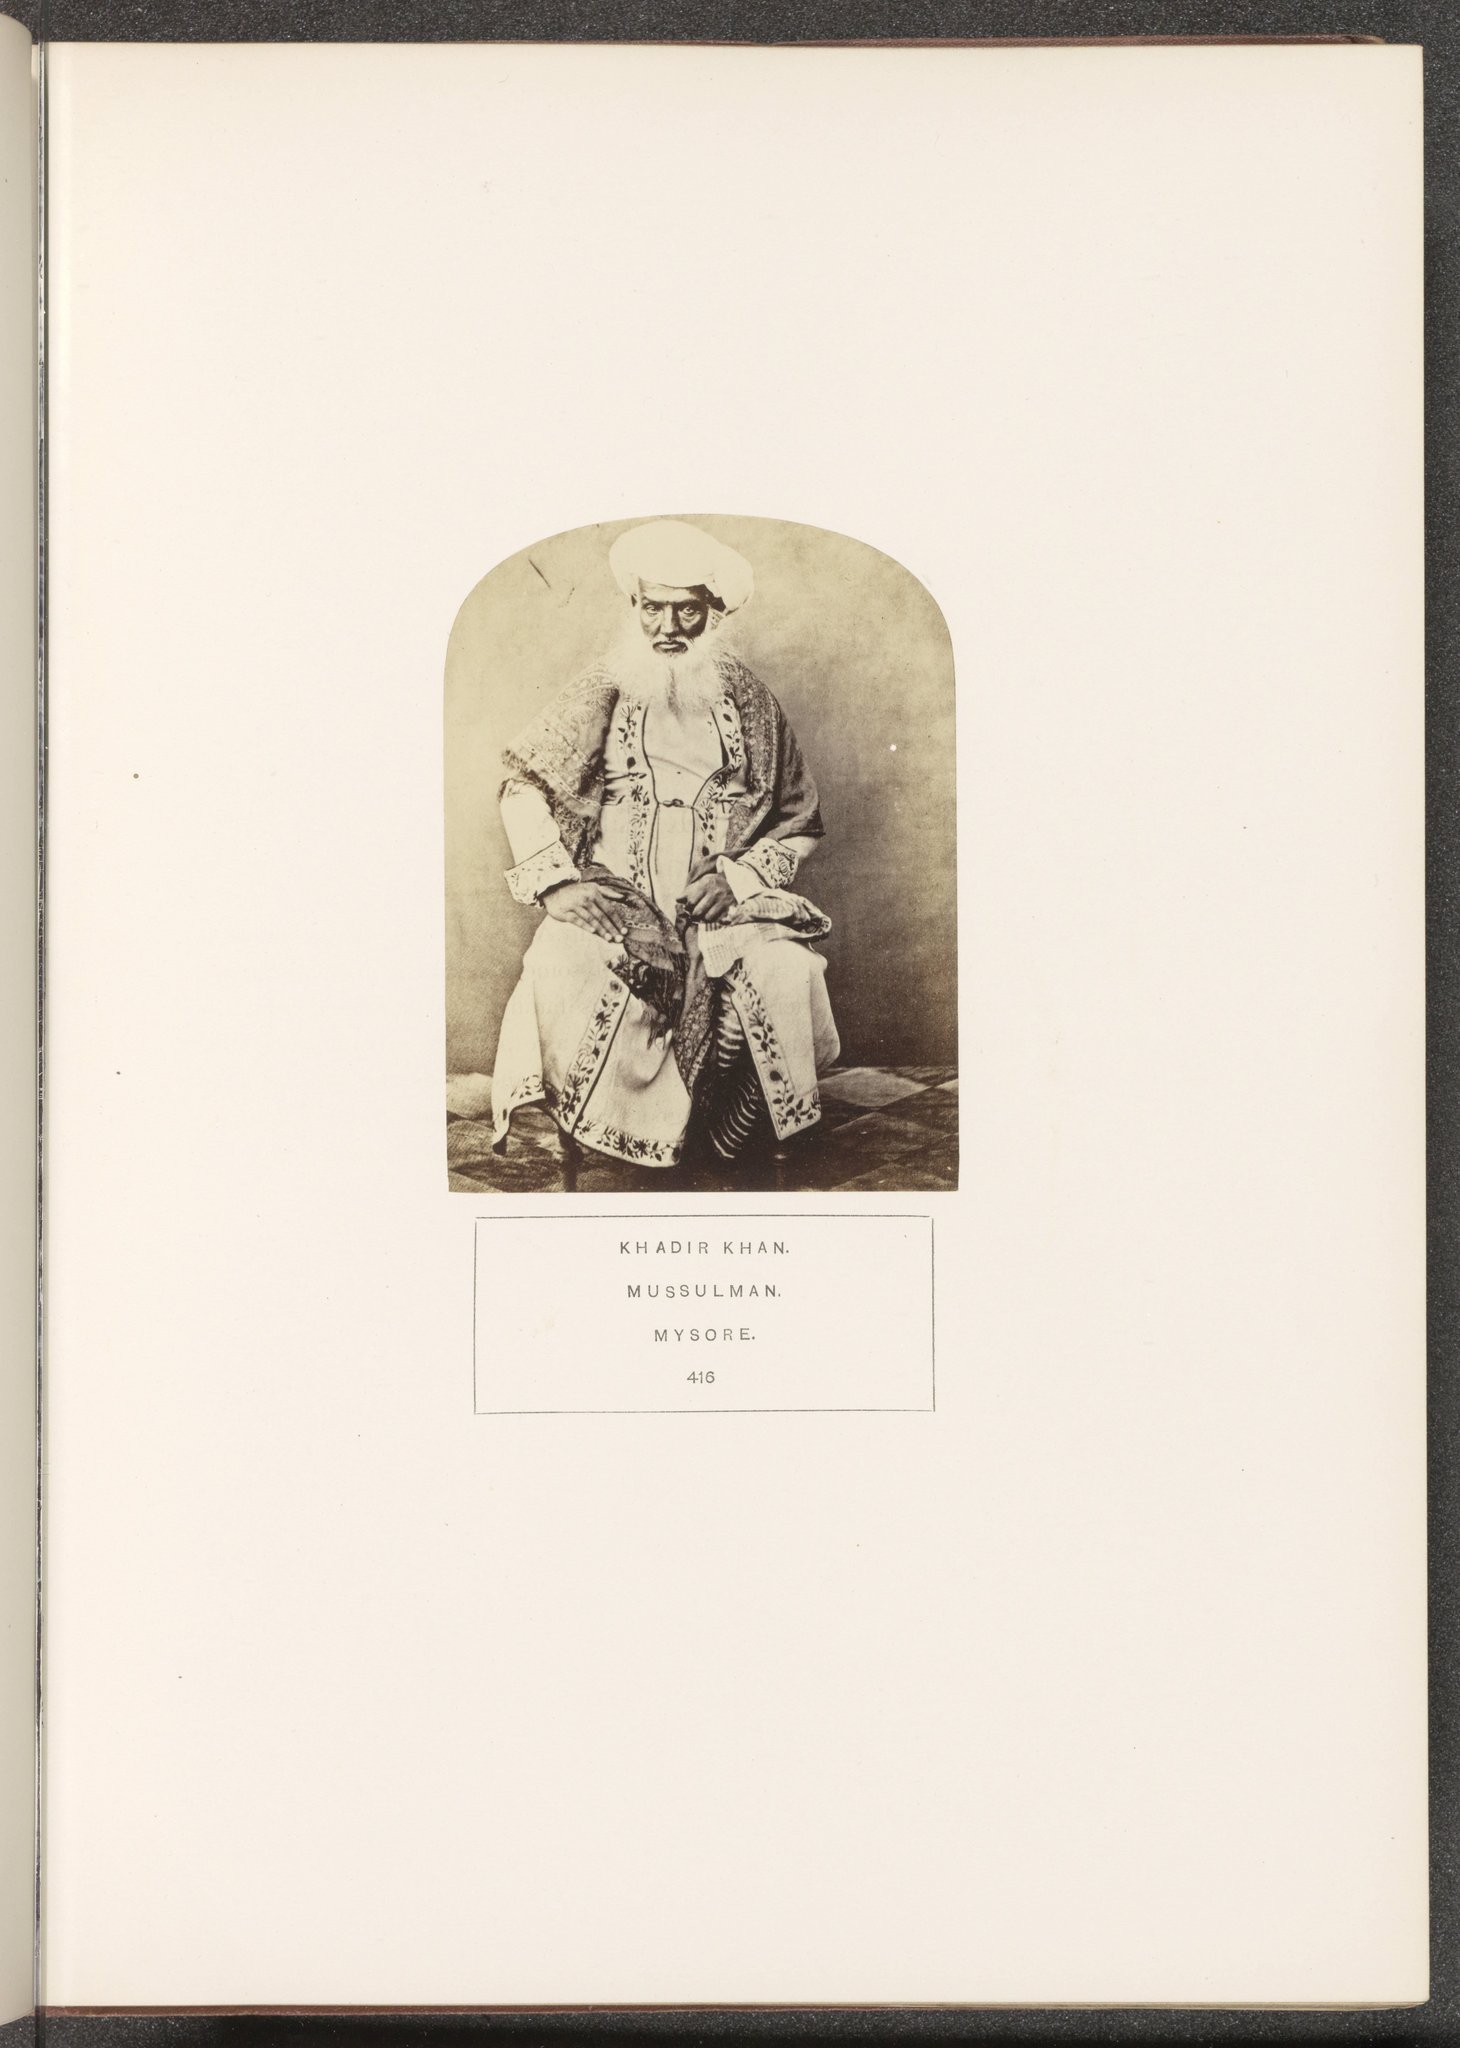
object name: page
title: Portrait of Khadir Khan of Mysore, Karnataka, India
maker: Anonymous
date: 1865-1875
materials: photographic support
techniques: albumen print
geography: mysore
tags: head-gear: turban, human races; peoples; nationalities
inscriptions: inscription: ‘KHADIR KHAN./ MUSSULMAN./ MYSORE.’, number: ‘416.’